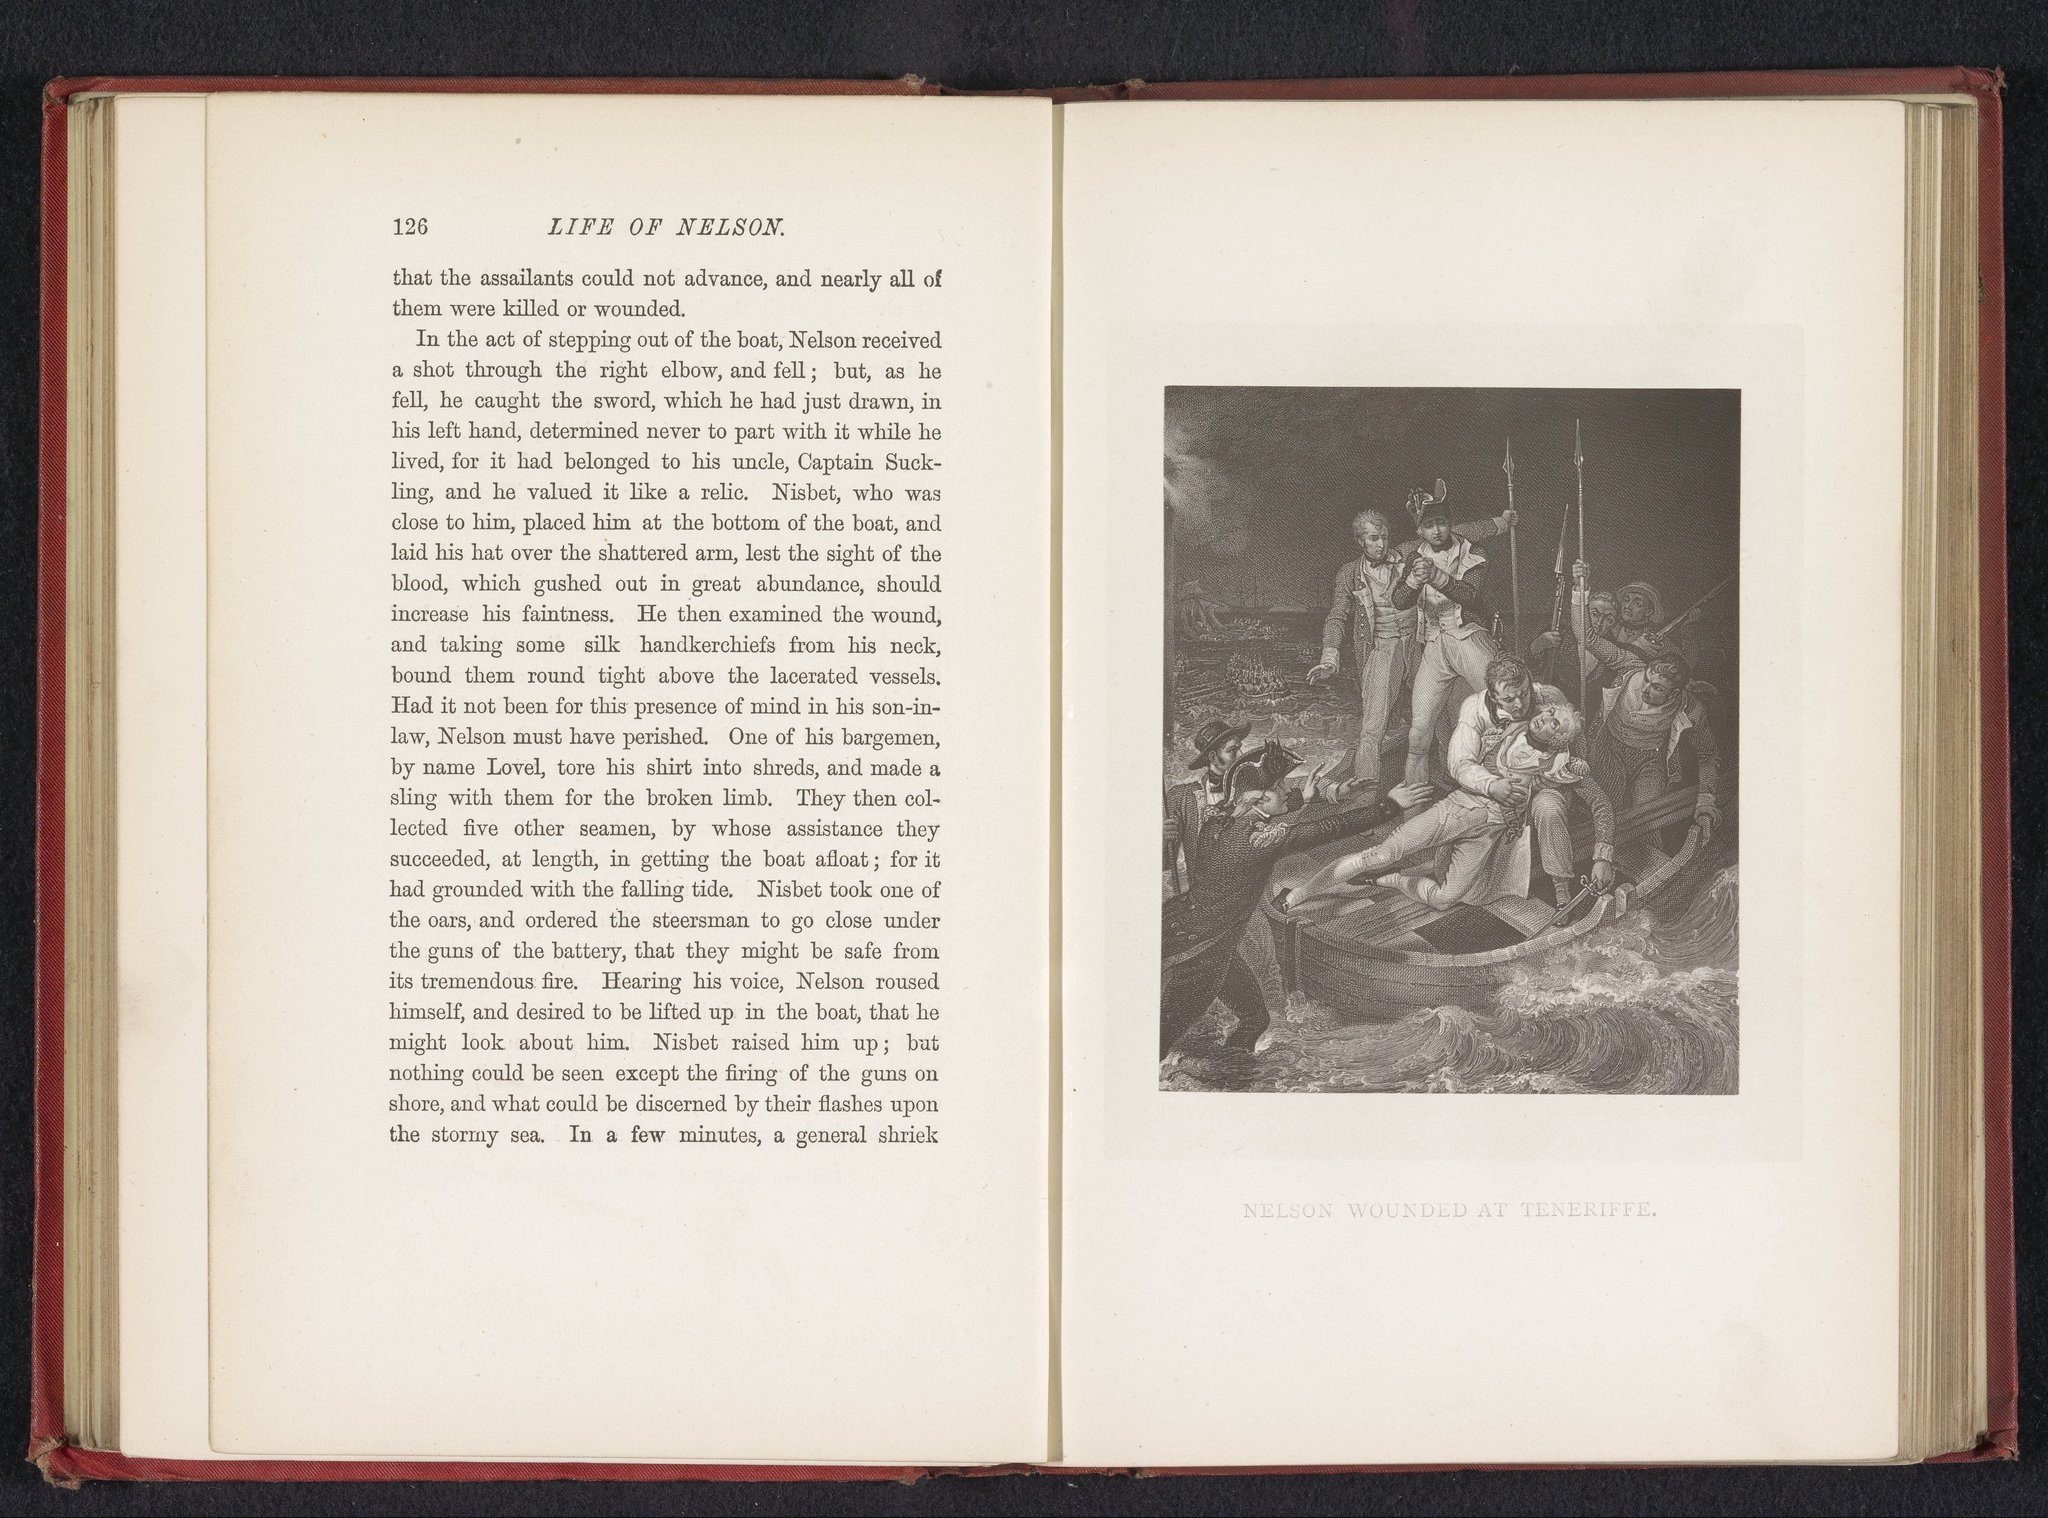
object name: page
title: Fotoreproductie van een prent van Horatio Nelson die gewond aankomt op Tenerife na de zeeslag bij Kaap Sint-Vincent in 1797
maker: Anonymous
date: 1877-1887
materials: paper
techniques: woodburytype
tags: horatio nelson (hertog van bronte), putting out of action by wounding, battle